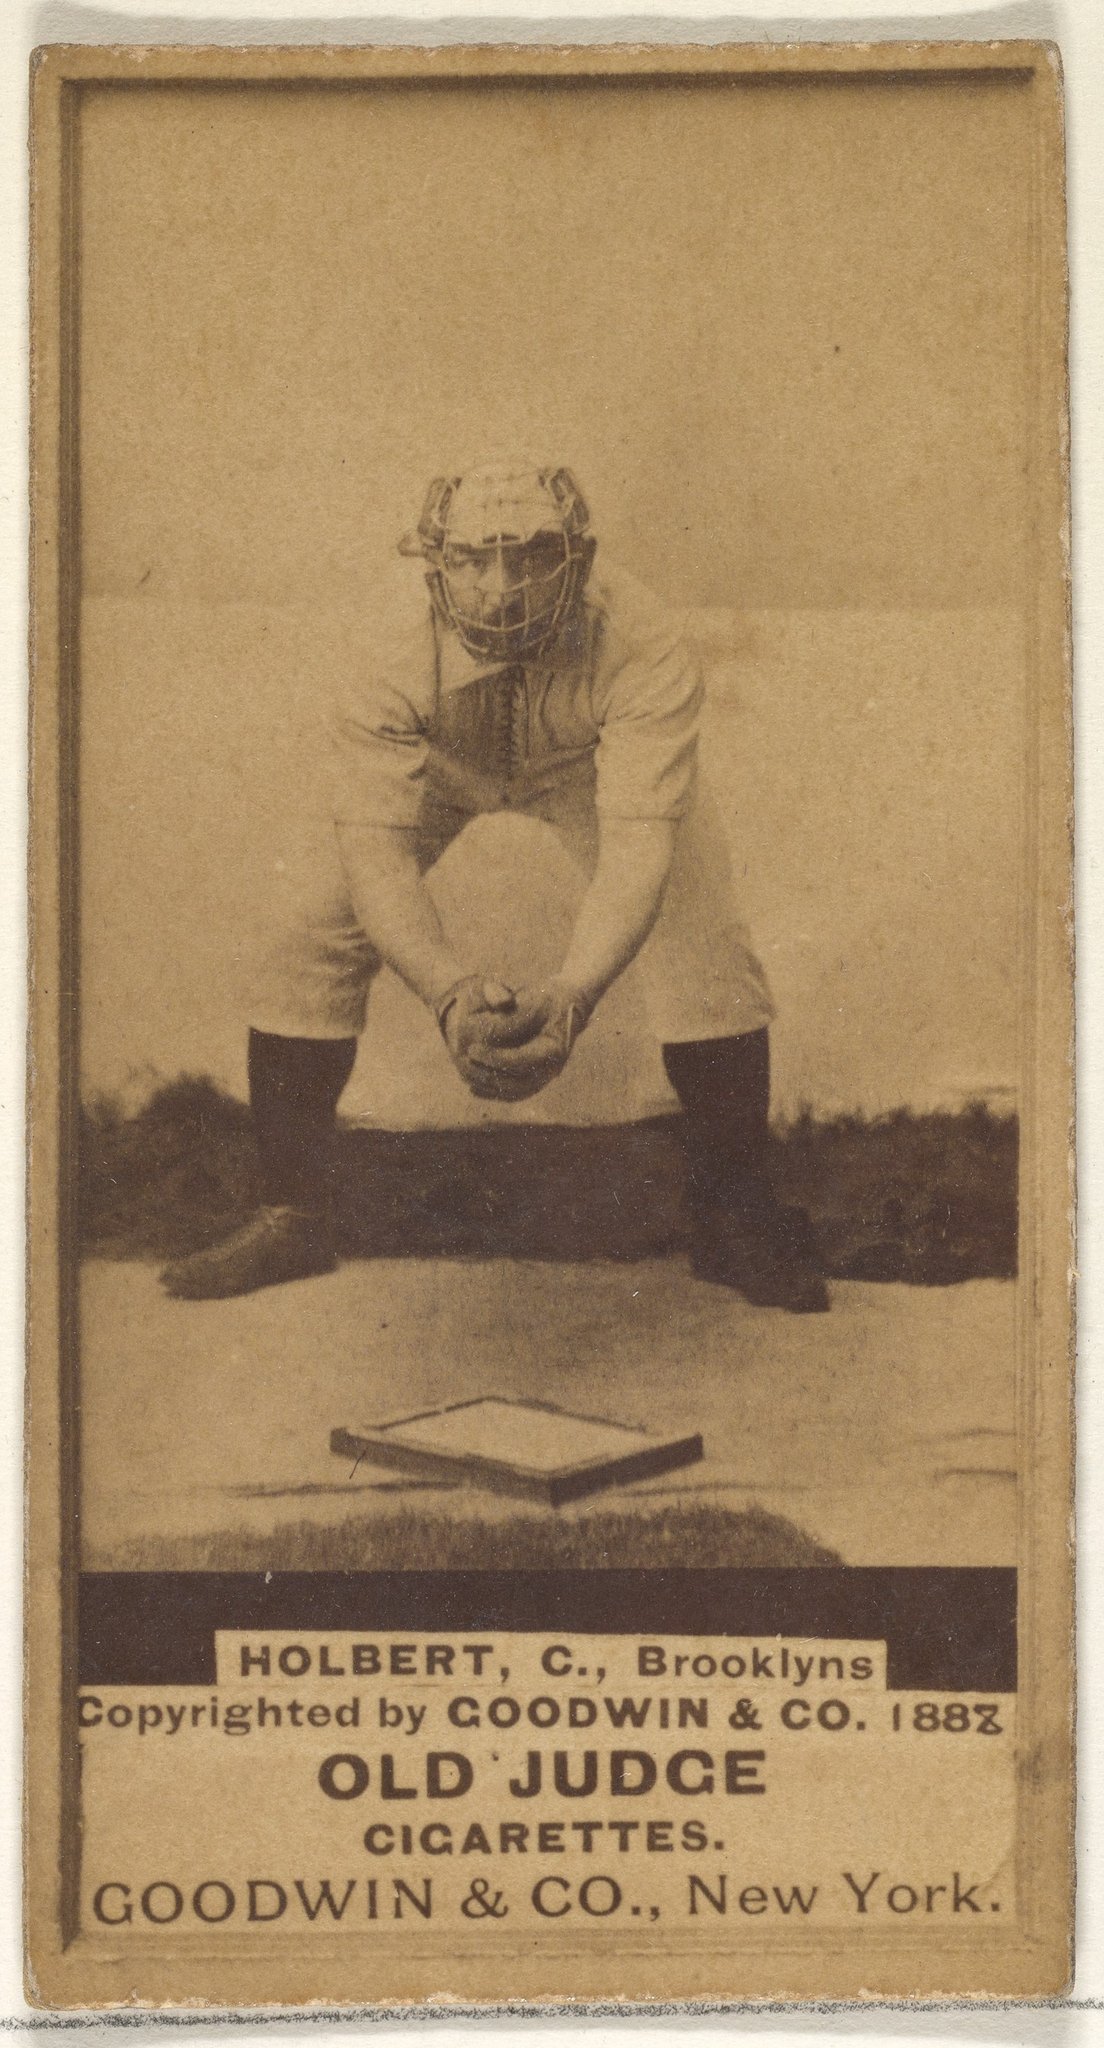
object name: baseball card, photograph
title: Holbert, Catcher, Brooklyn Bridegrooms, from the Old Judge series (N172) for Old Judge Cigarettes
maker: goodwin & company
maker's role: publisher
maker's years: 1850-1950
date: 1888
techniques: albumen silver print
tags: men,portraits,baseball,athletes